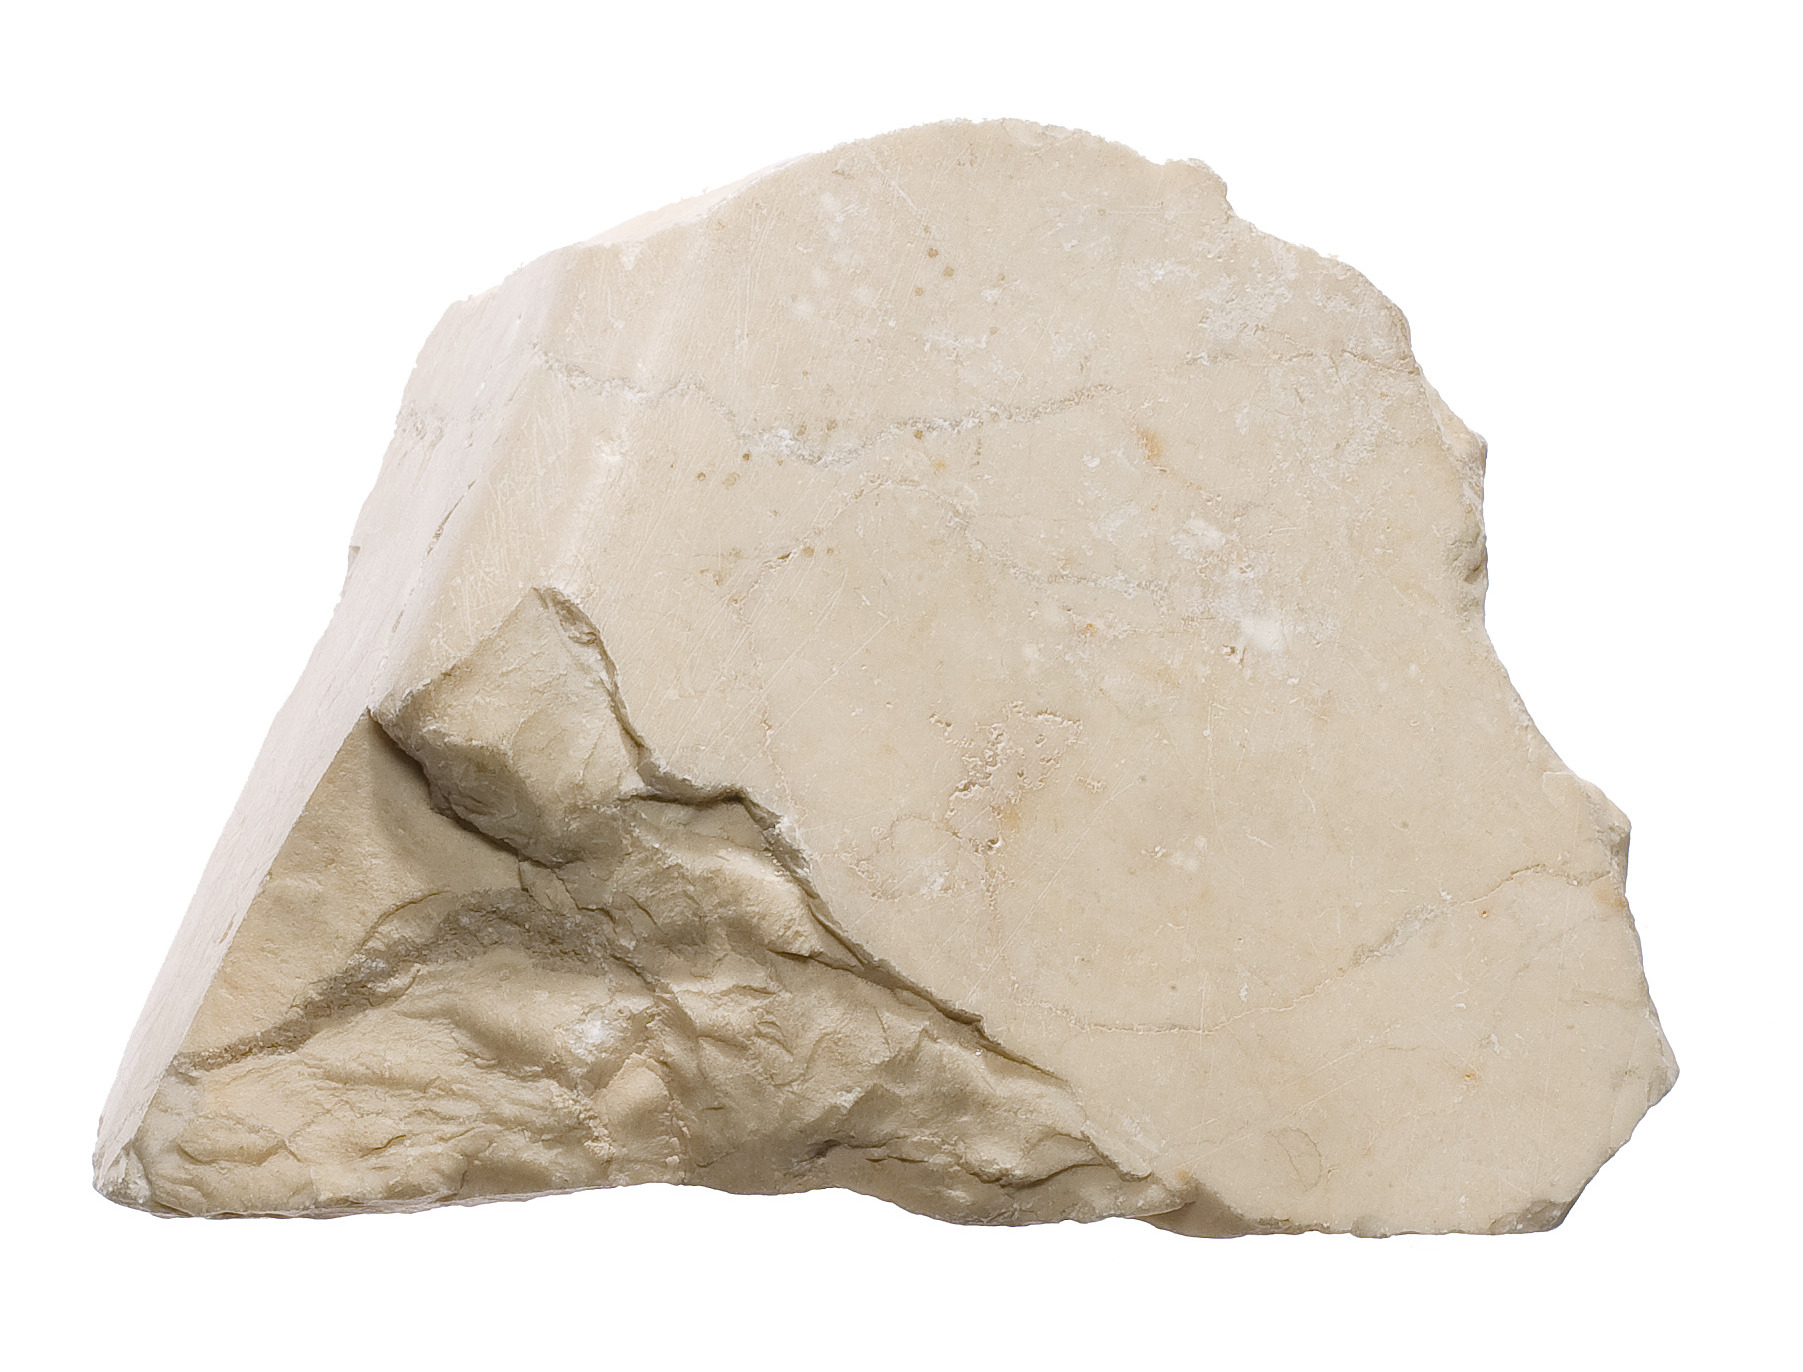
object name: fragment, beveled corner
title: Fragment of block with beveled corner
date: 1353-1336 BCE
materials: limestone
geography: egypt